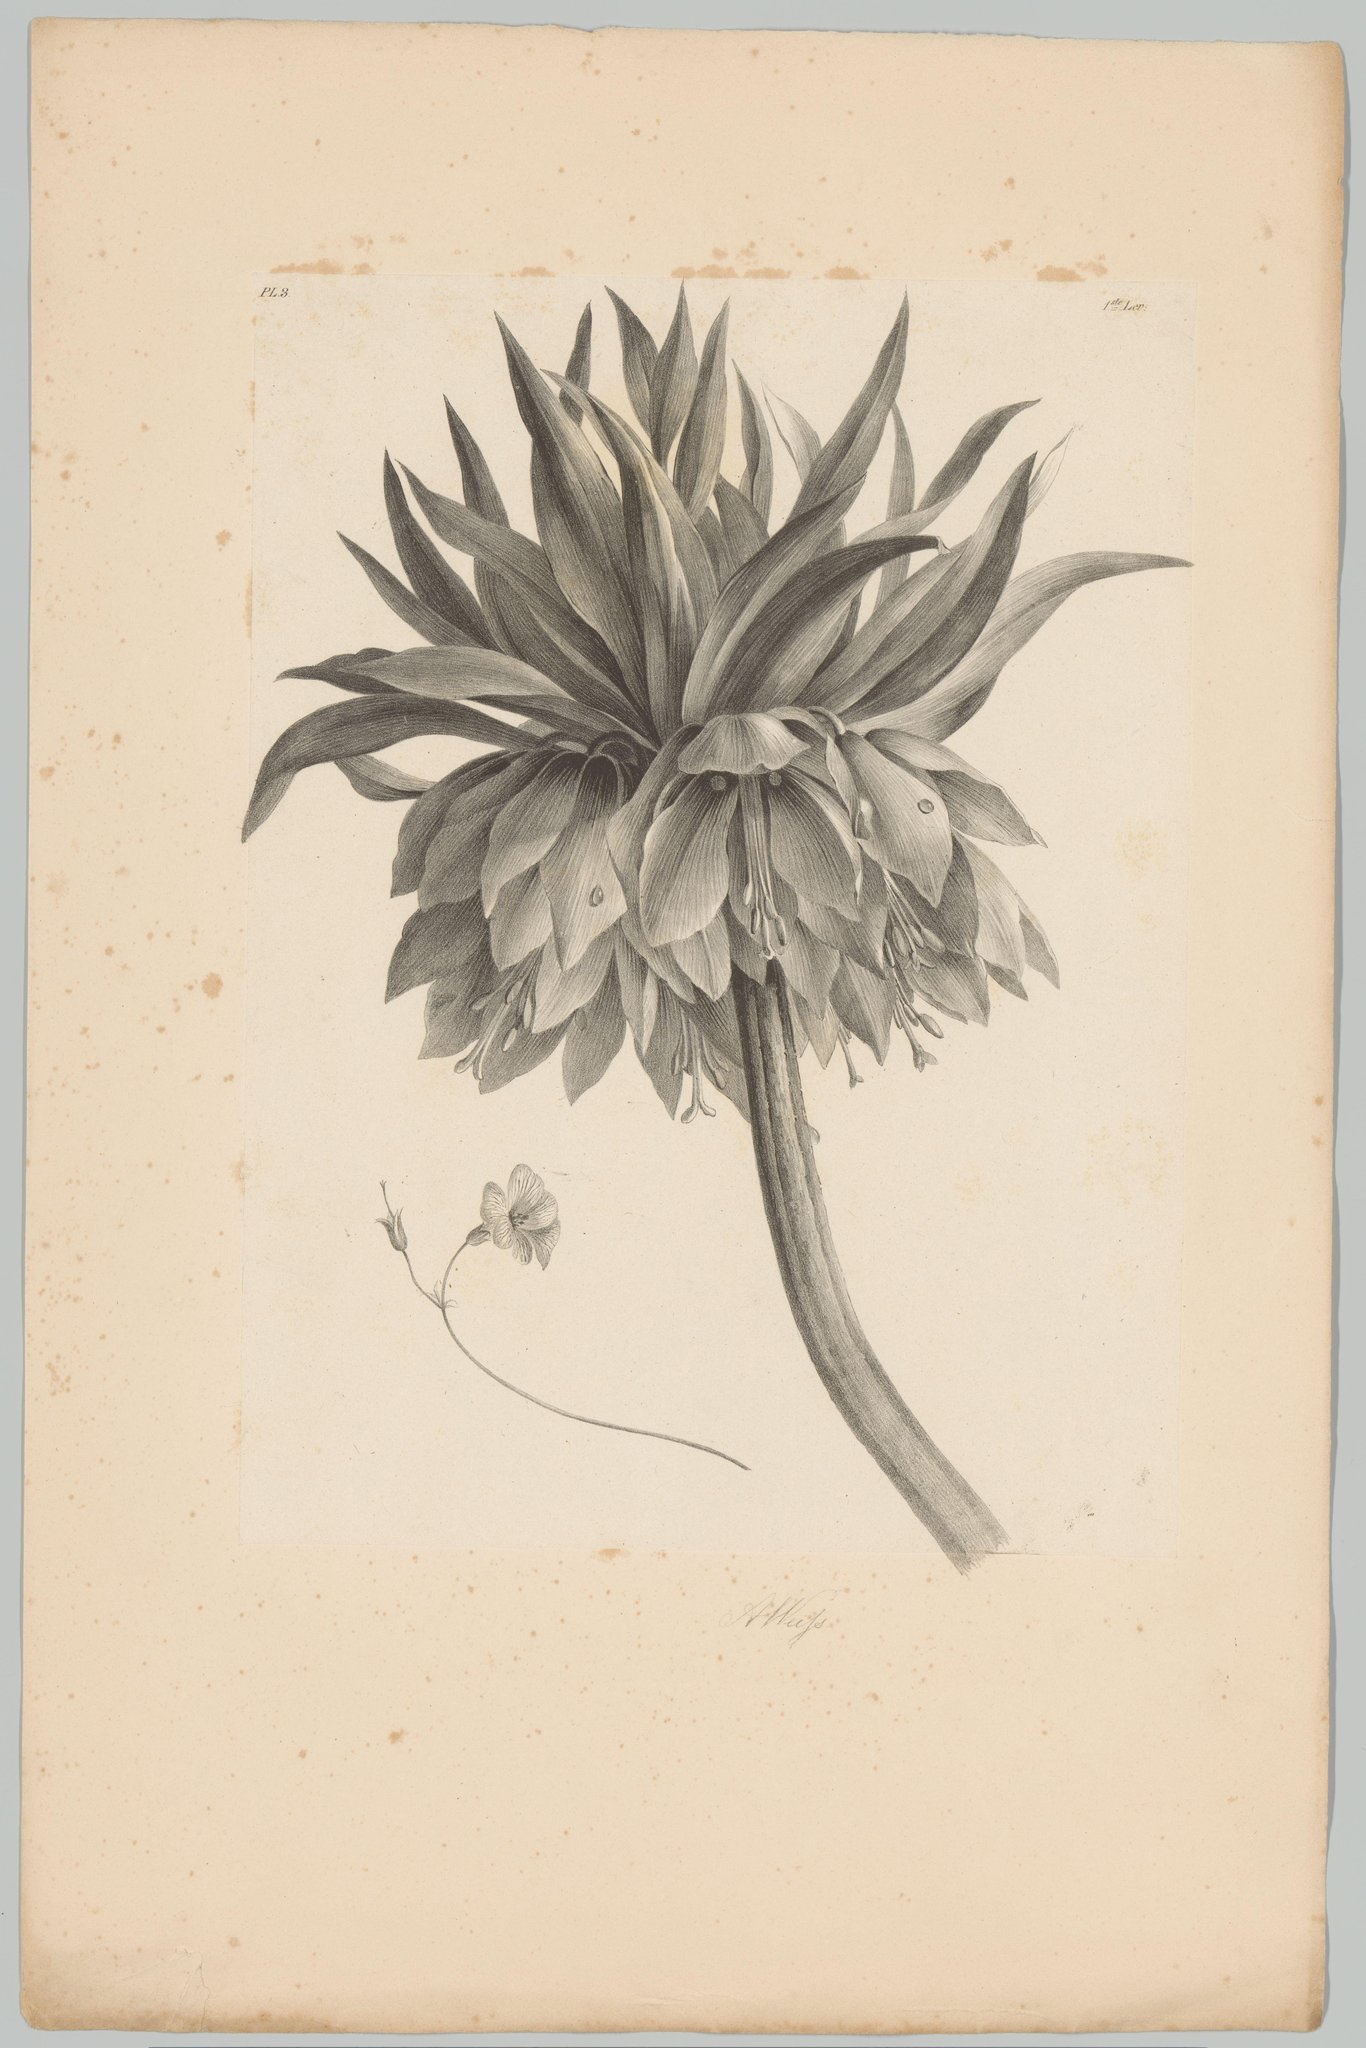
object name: print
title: Bloem en Fruit Studien (...) 3de aflevering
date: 1820-1833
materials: paper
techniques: lithograph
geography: amsterdam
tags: flowers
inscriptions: collector's mark: Lugt 2228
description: Rechts boven genummerd 1ste Lev. Onderdeel van een omslag met in totaal zevenenzeventig lithografieën van bloemen en fruit.